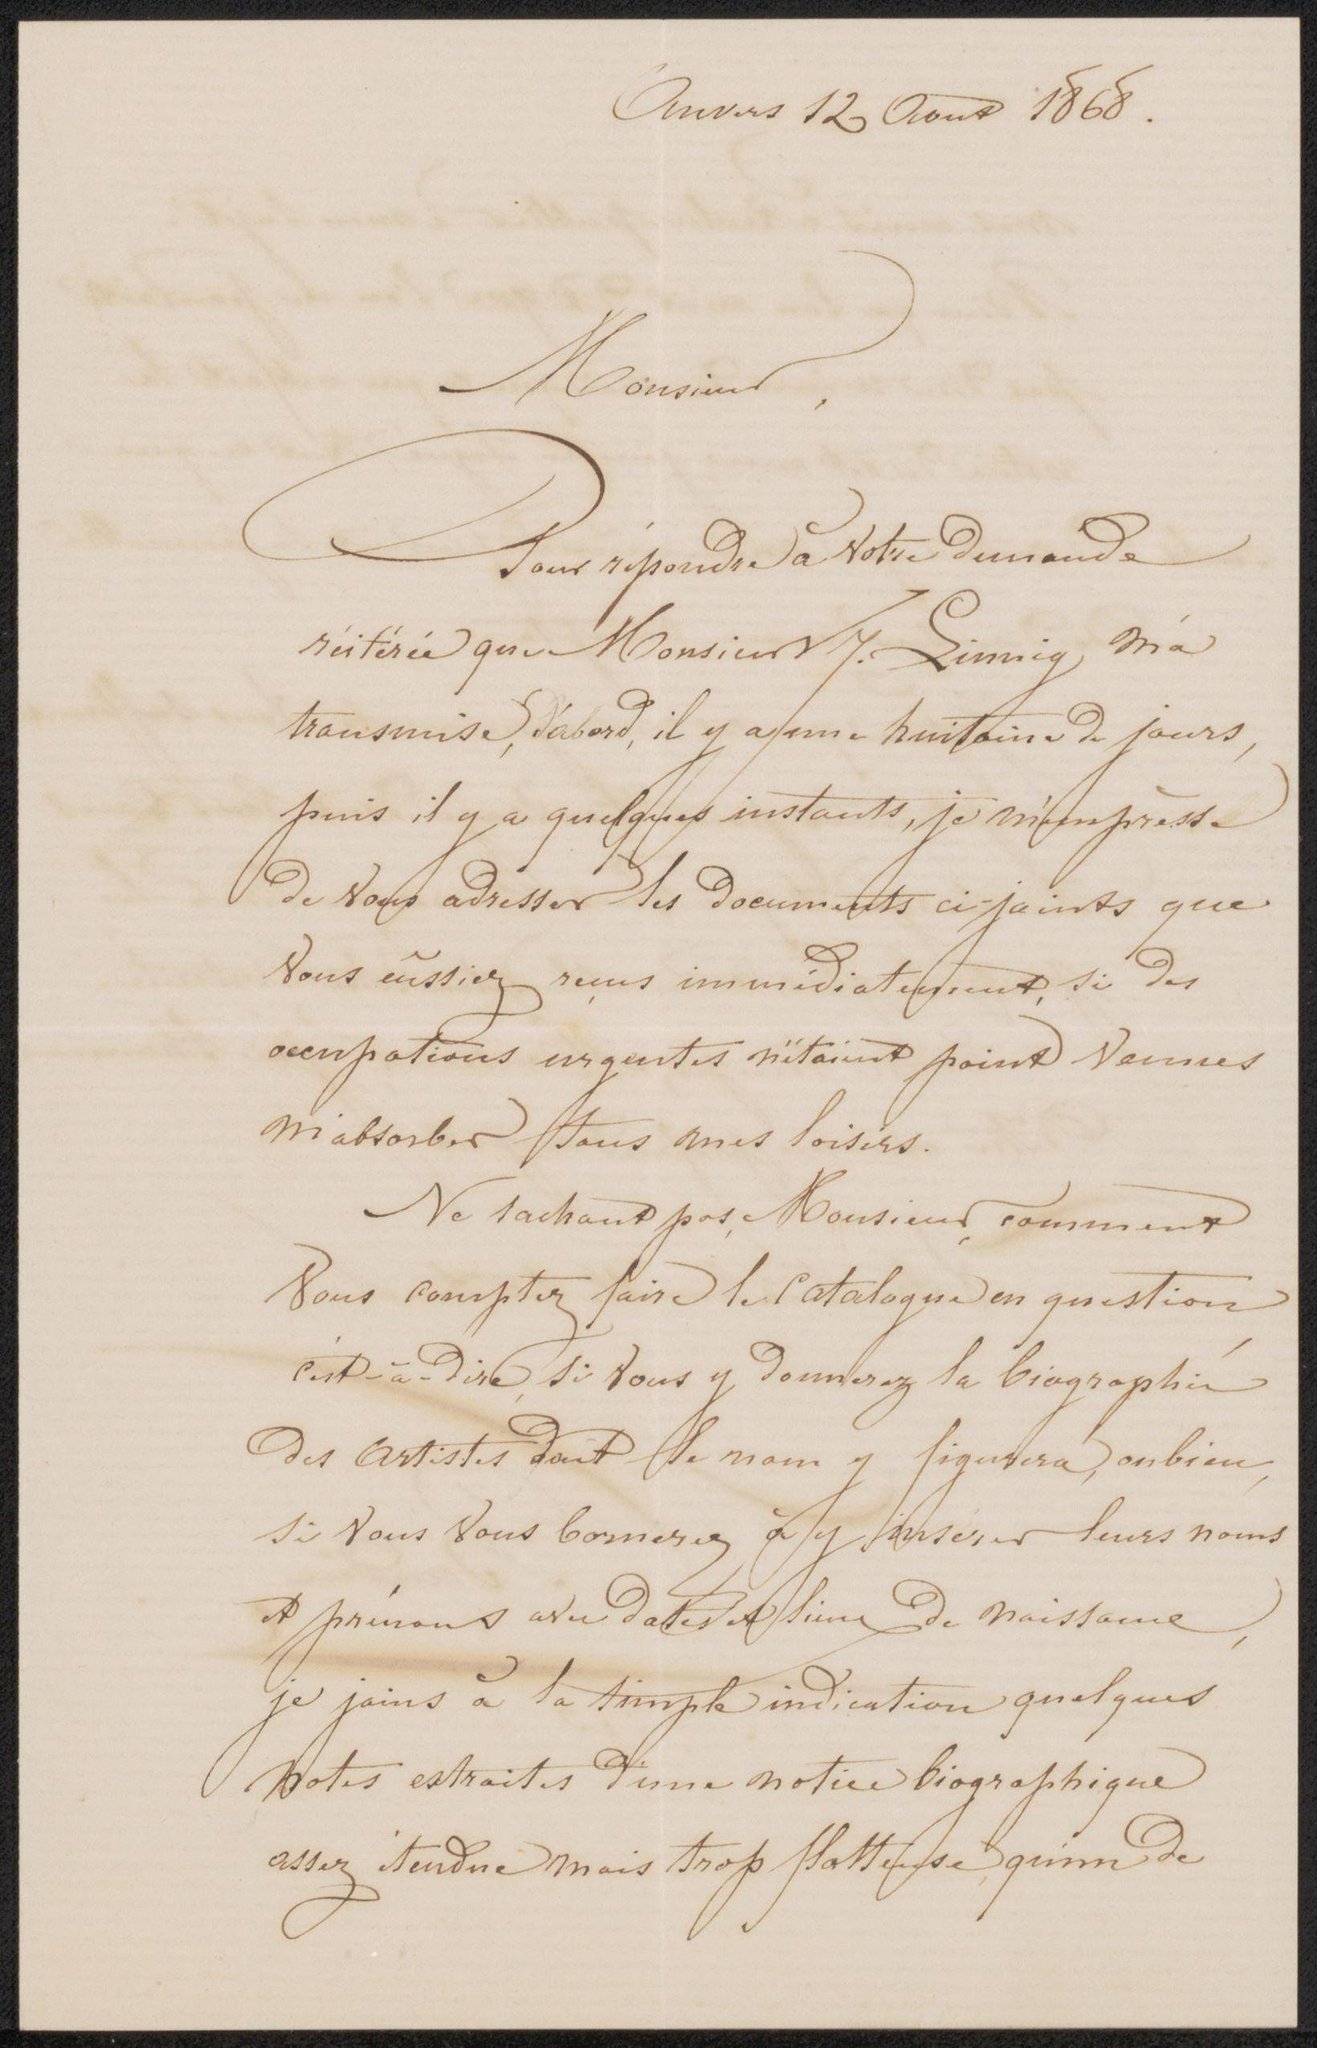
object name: letter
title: Brief aan Ary Johannes Lamme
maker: narcisse alexis joseph léopold baudin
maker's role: painter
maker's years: 1820-1890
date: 1868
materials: ink, paper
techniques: pen, writing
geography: antwerp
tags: antwerp, print maker, draughtsman, jean théodore joseph linnig, dordrecht, ary johannes lamme, education, tuition of the artist (in general), printed matter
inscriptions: collector's mark: Lugt 2228